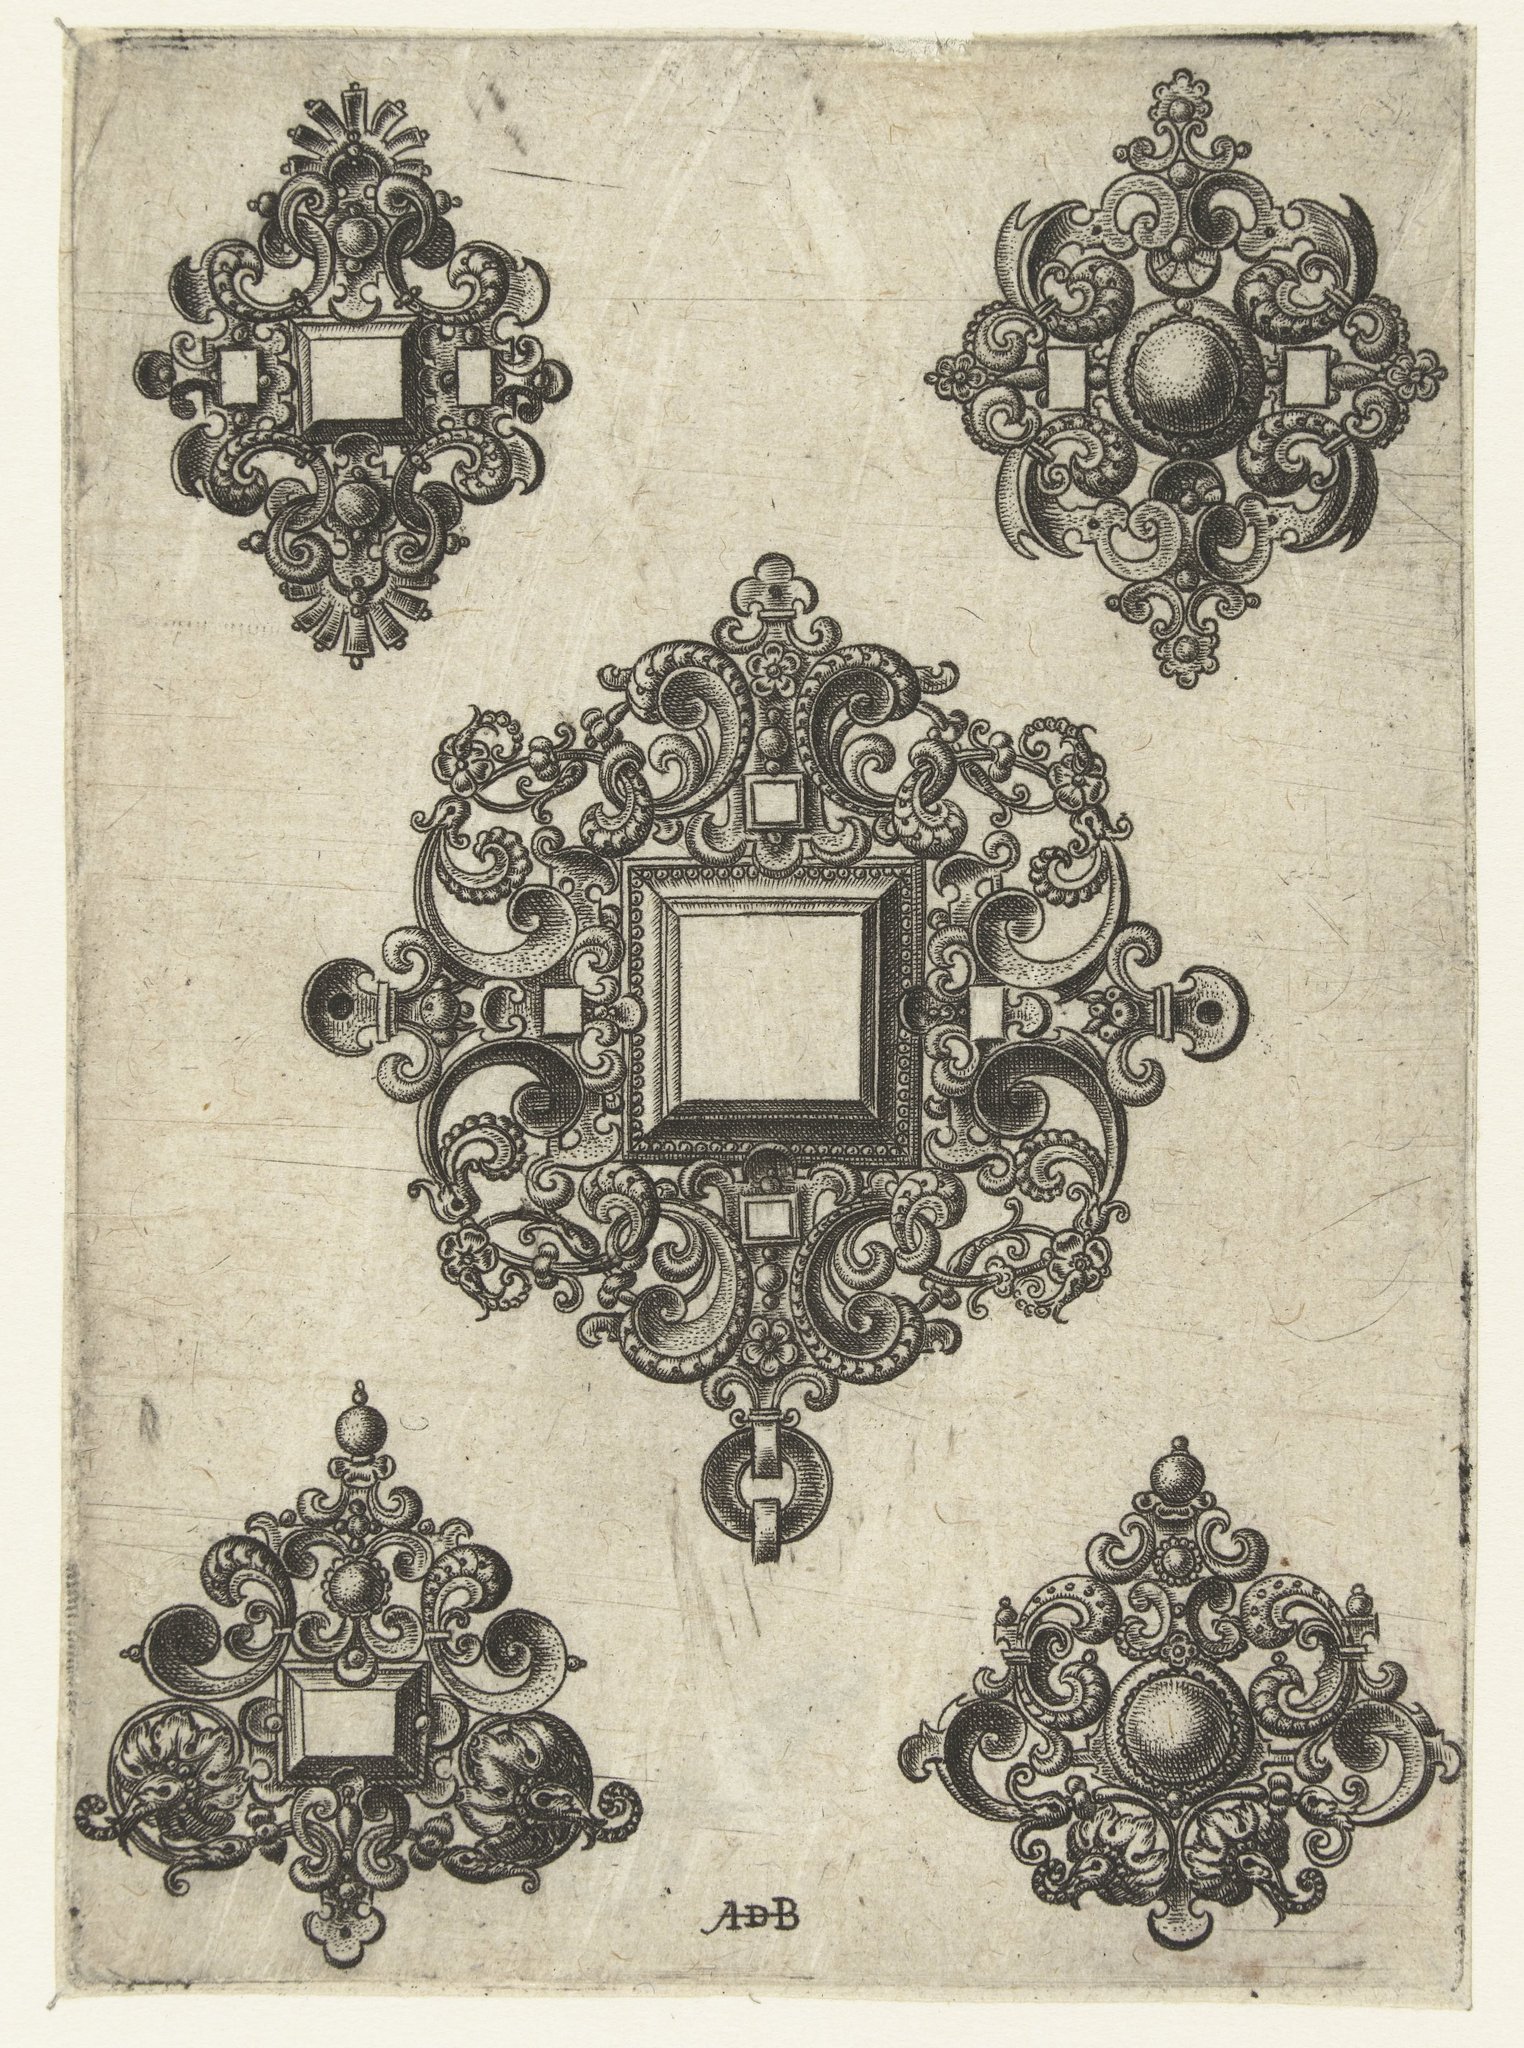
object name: ornament print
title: Sieraden: parels en edelstenen in zettingen van grotesken, rolwerk en arabesken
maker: abraham de bruyn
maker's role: print maker, publisher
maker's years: 1540-1587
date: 1550-1587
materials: paper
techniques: engraving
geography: netherlands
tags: brooch, agraffe, clasp, pendant, trinket, 'breloque'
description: Hanger met drie vierkante stenen. In de hoeken van het blad vier broches. Eén van 6 bladen uit een serie van mogelijk 7 of 8.